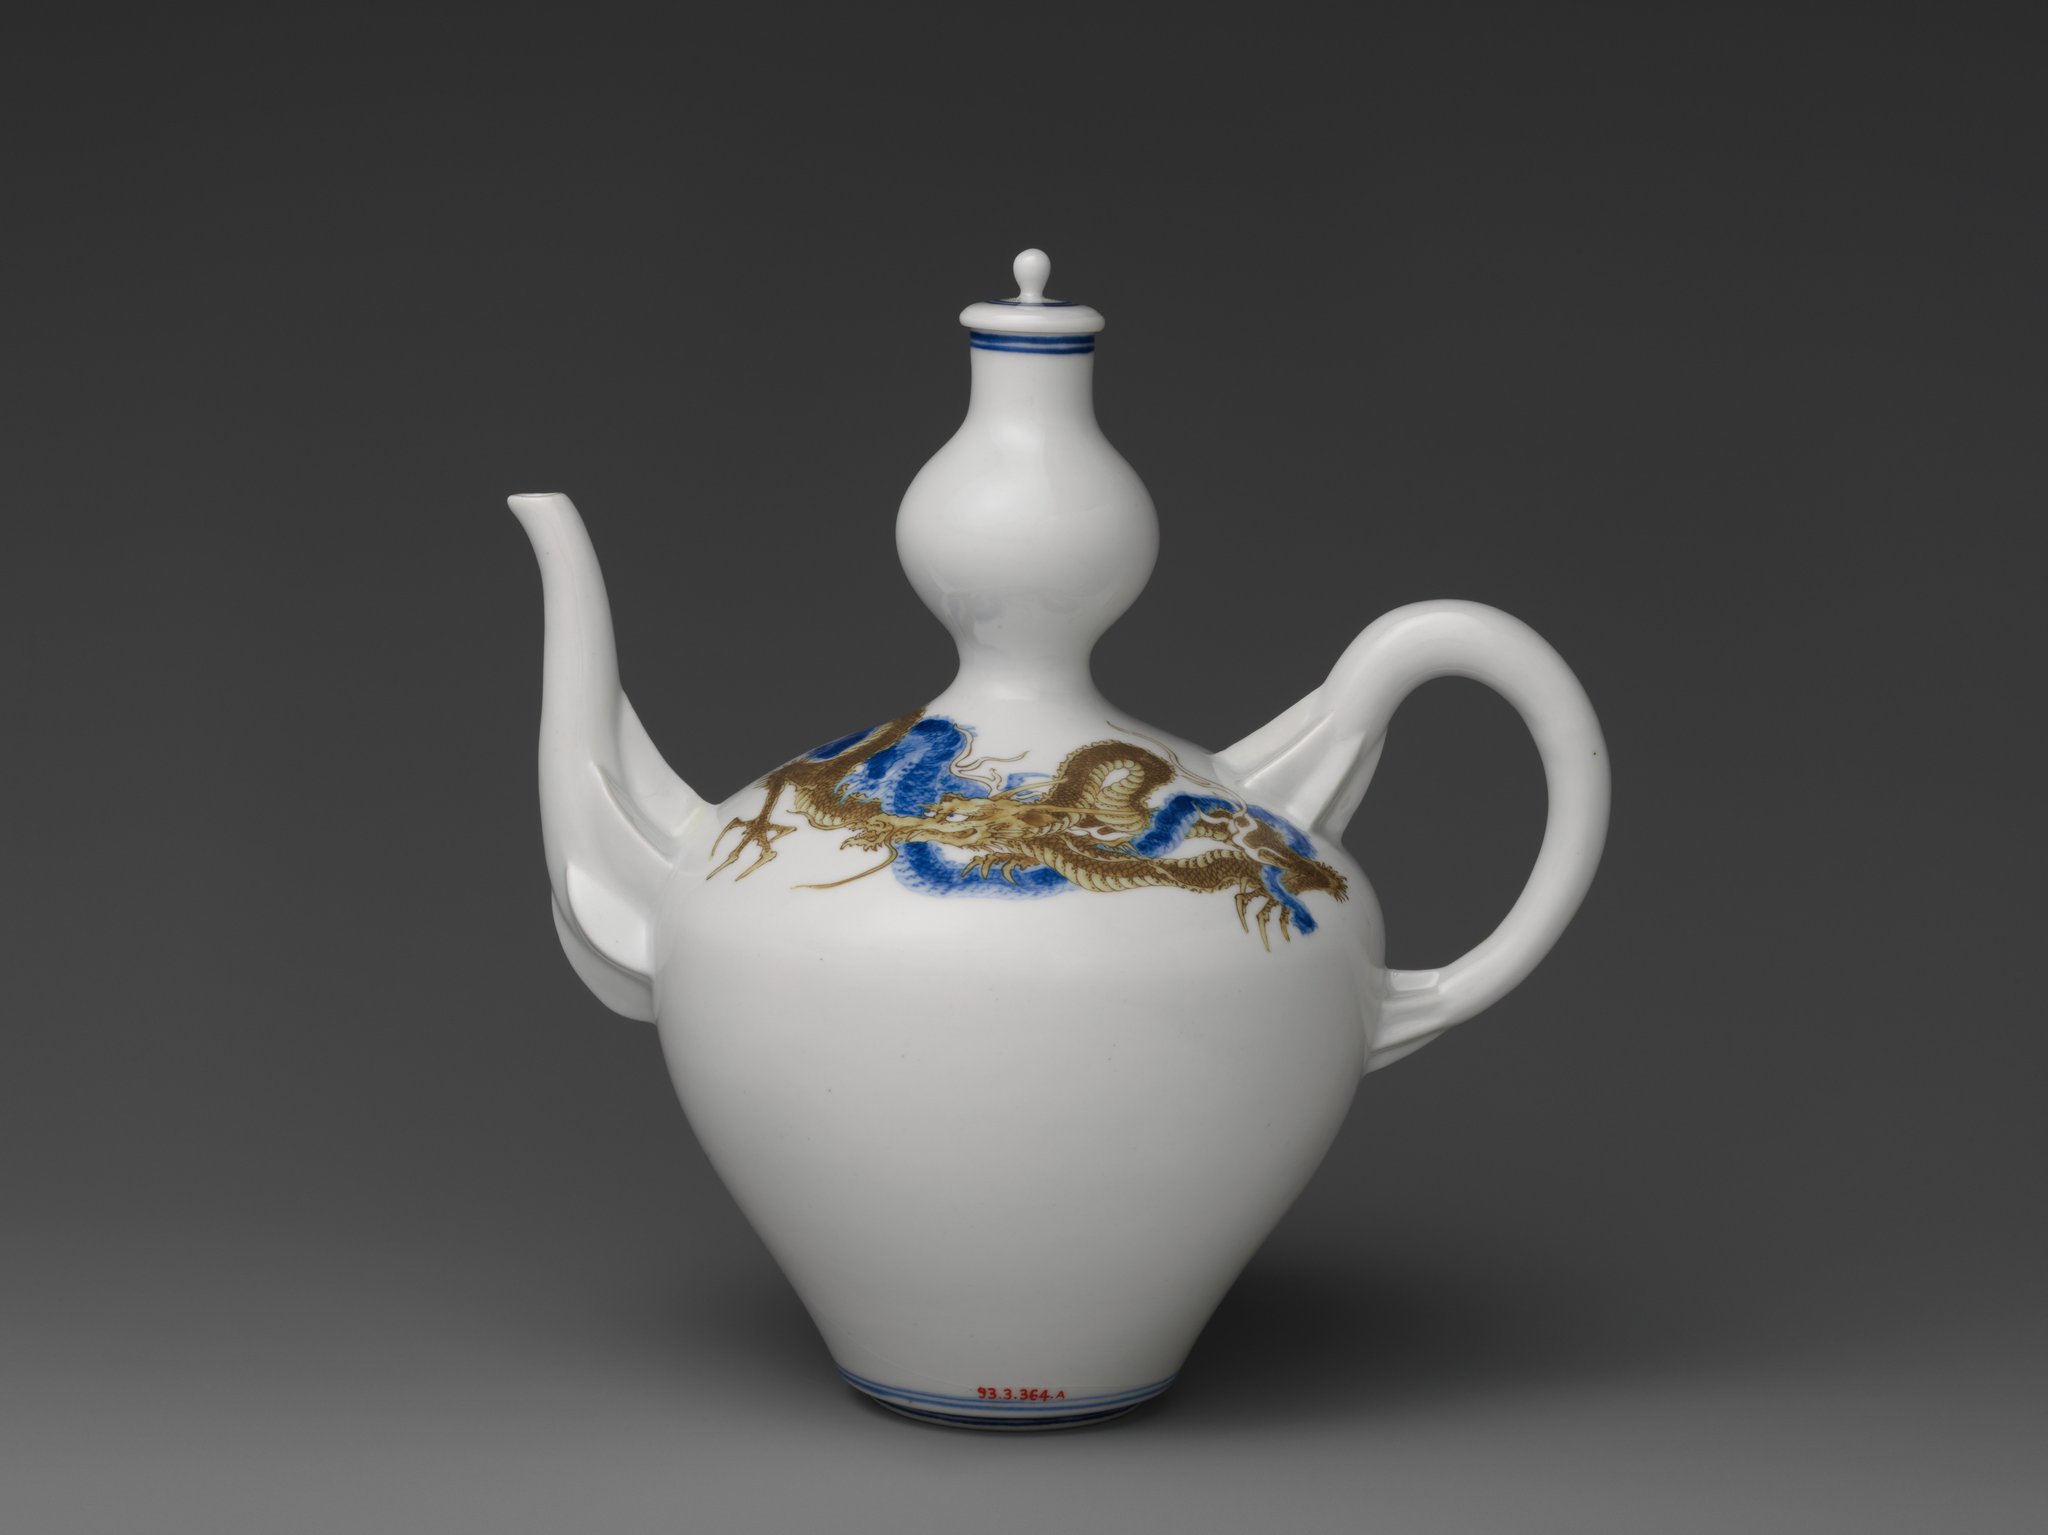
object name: wine pot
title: Ewer with Dragon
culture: japanese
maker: makuzu kōzan i (miyagawa toranosuke)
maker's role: artist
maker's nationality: japanese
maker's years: 1842-1916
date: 1867-1900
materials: porcelain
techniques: underglaze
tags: dragons